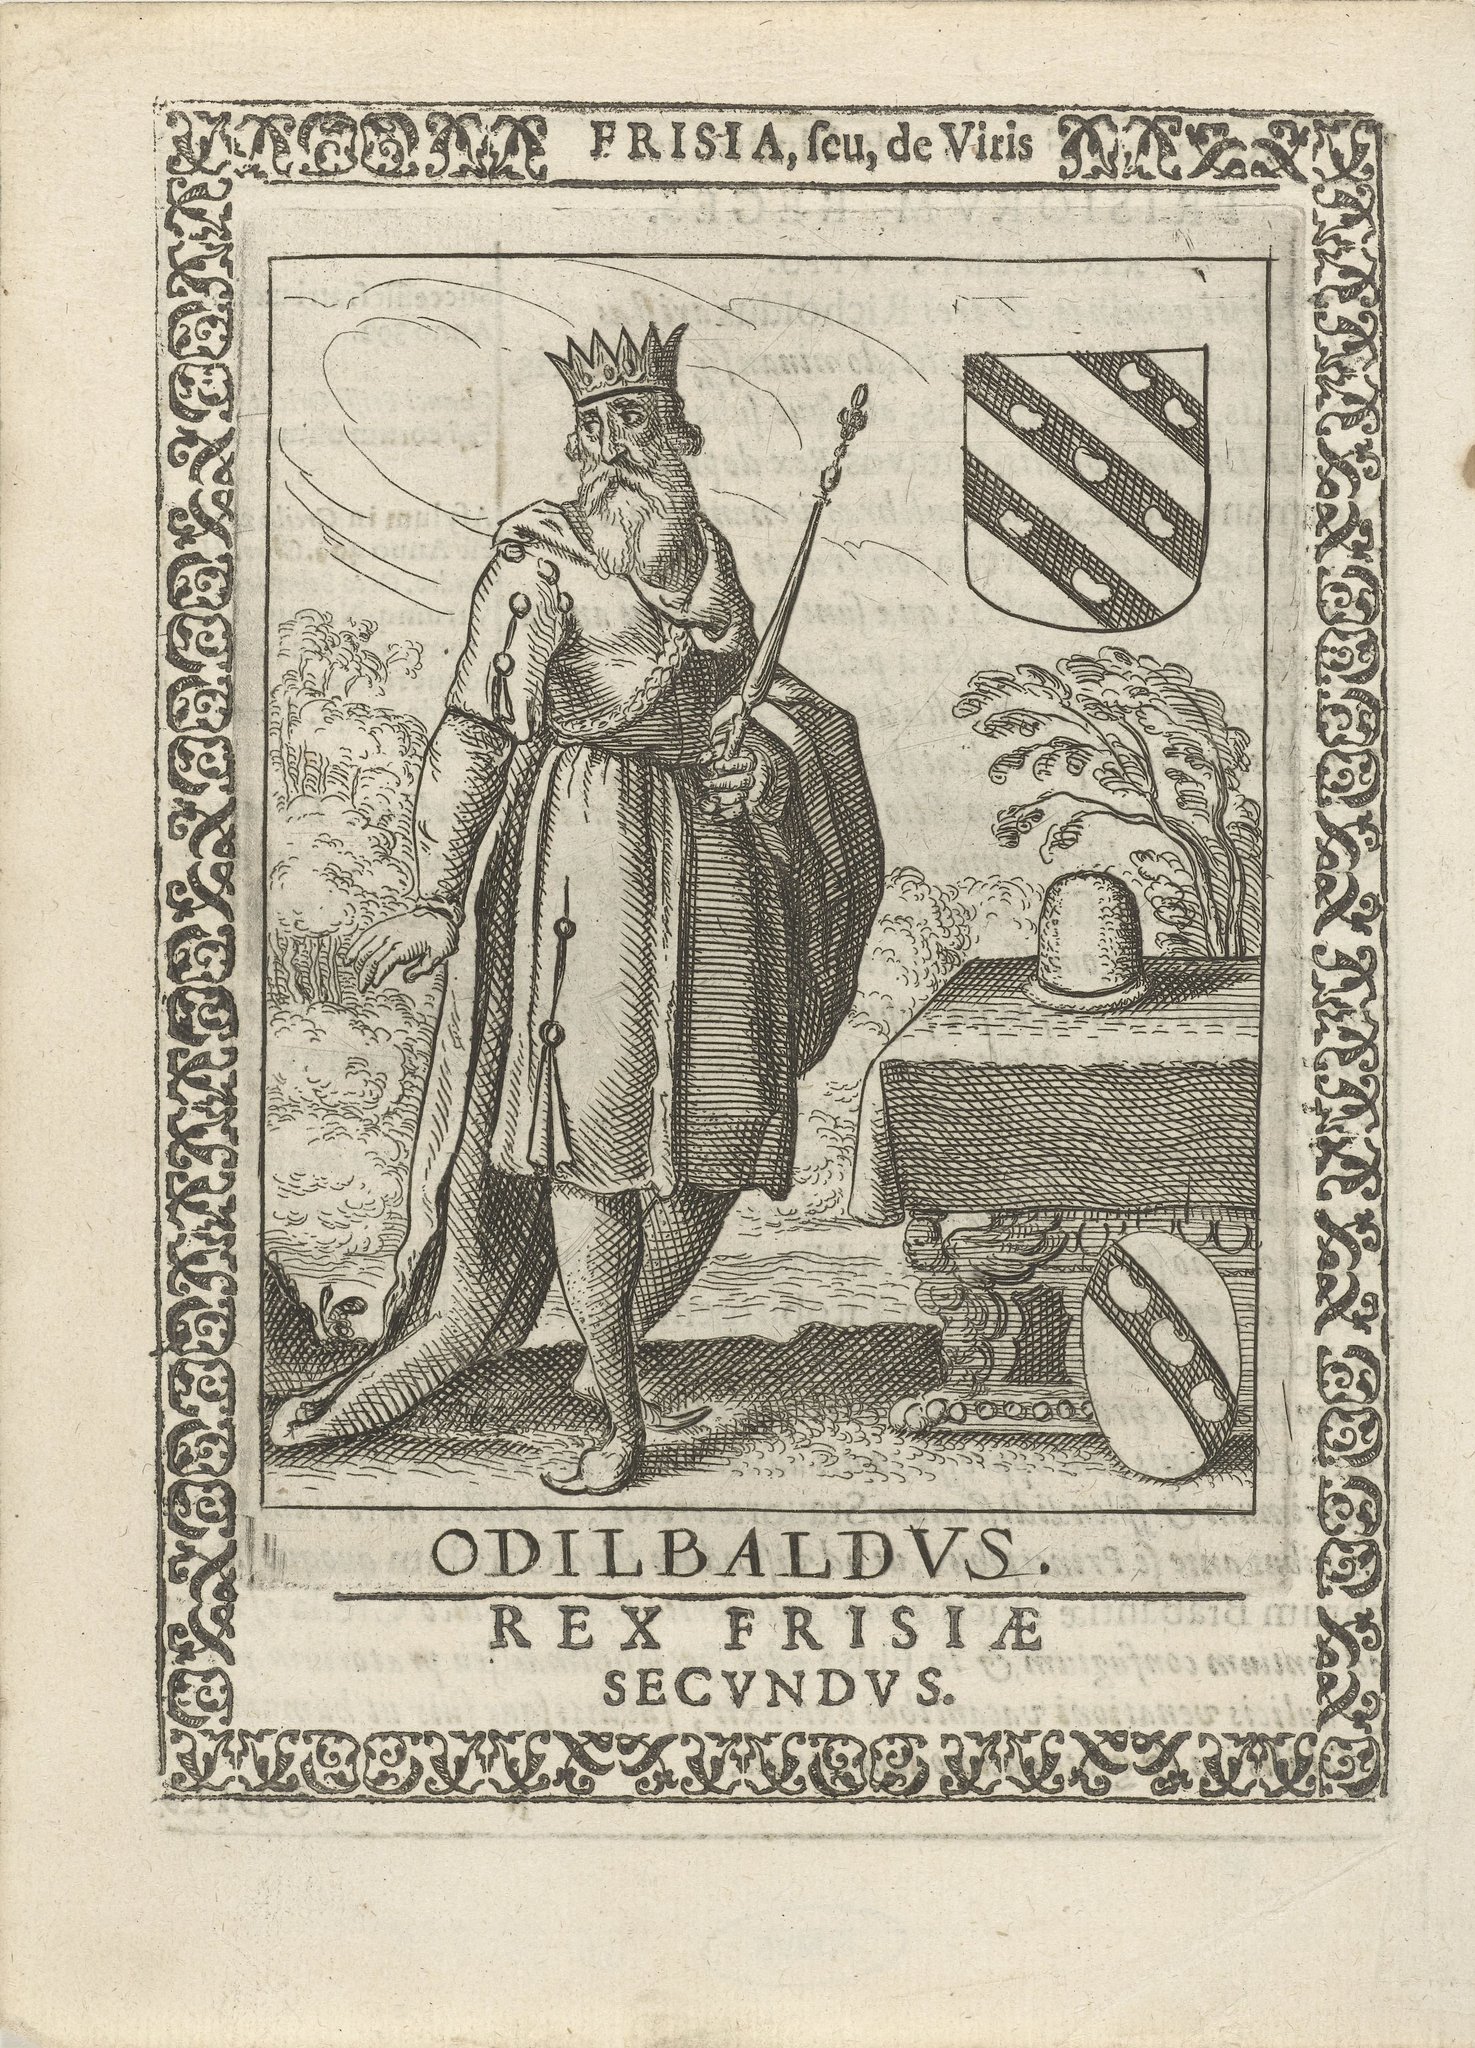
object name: print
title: Frisia, sev, de Viris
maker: pieter feddes van harlingen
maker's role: painter, print maker, publisher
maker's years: 1586-1623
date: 1618-1620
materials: paper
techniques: etching, letterpress printing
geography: friesland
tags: ruler, sovereign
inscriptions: collector's mark: Lugt 2228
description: Odilbald, tweede koning der Friezen. Staande ten voeten uit, scepter in de hand. In een ornamentale omlijsting. Illustratie, met tekst op achterzijde, afkomstig uit het boek: Frisia seu de viris rebusque Frisiae illustribus libri duo.